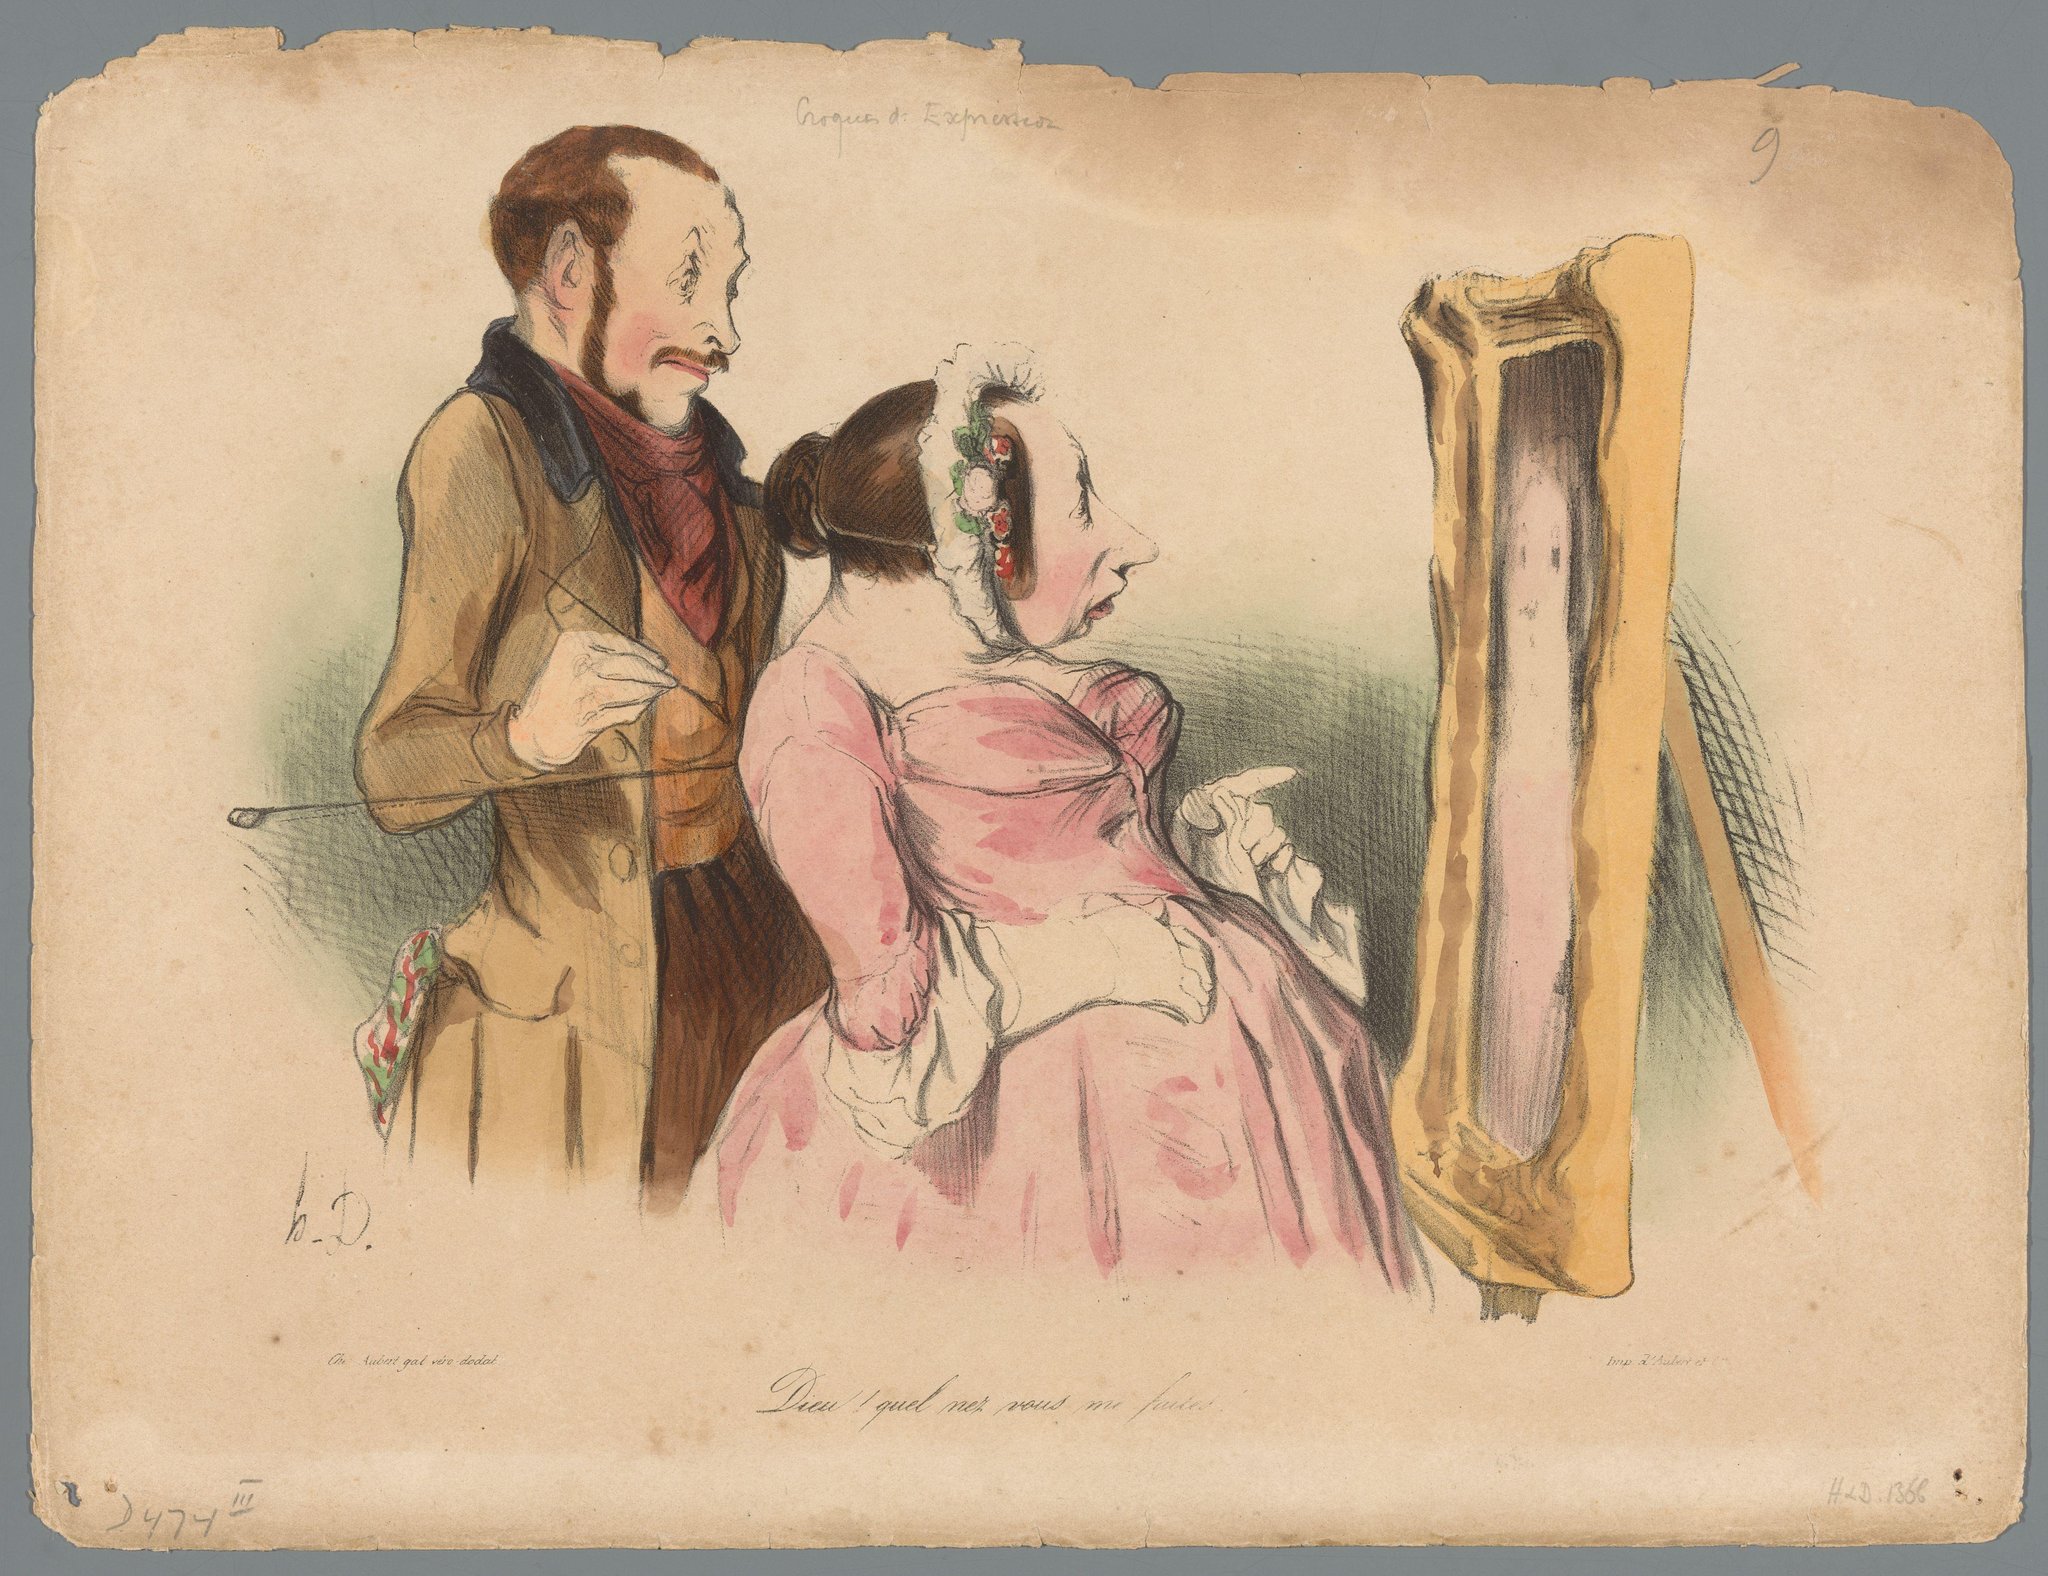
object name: cartoon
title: Dieu! Quel nez vous me faites!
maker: honoré daumier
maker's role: draughtsman, painter, print maker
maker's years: 1808-1879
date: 1838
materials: paper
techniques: hand coloring, lithograph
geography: paris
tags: artist's model, sitter, caricatures (human types), painter working from clothed model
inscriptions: collector's mark: Lugt 2228a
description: Prent mogelijk uit: Le Charivari, 29 april 1838.